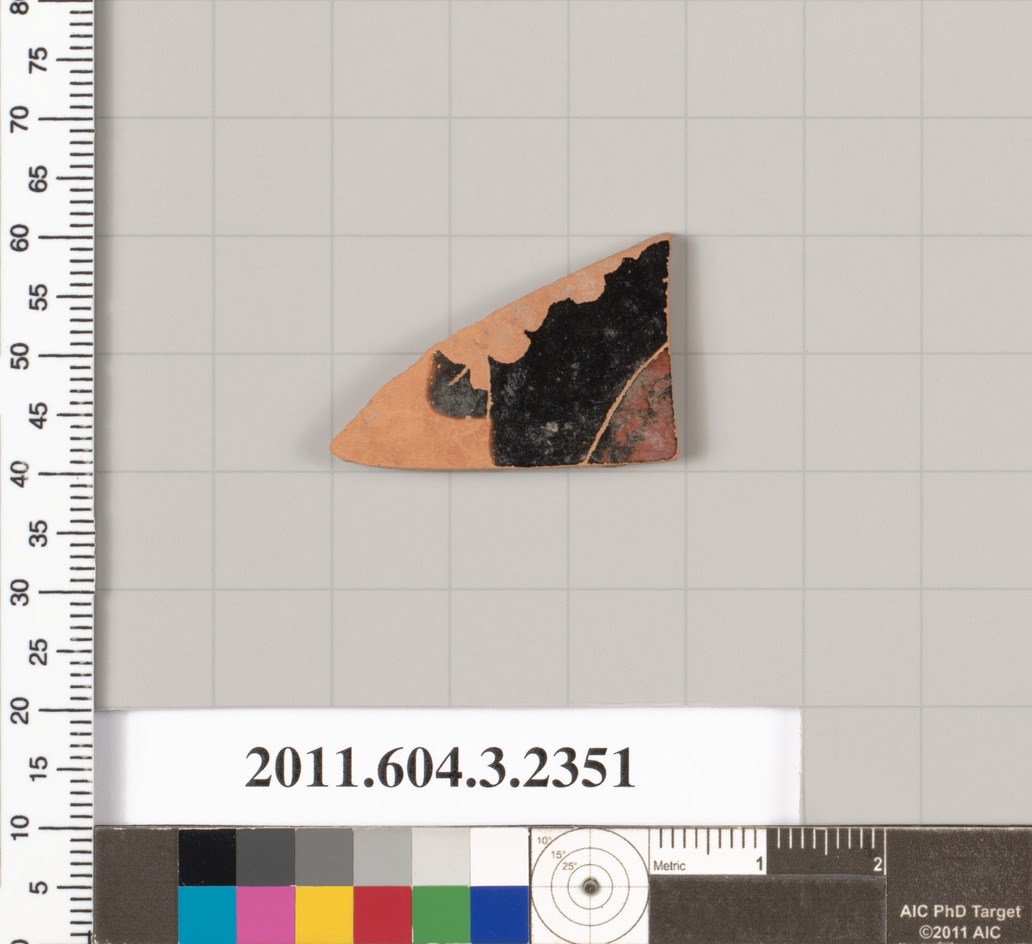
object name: kylix fragment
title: Terracotta fragment of a kylix: eye-cup (drinking cup)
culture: greek, attic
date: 530-510 BCE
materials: terracotta